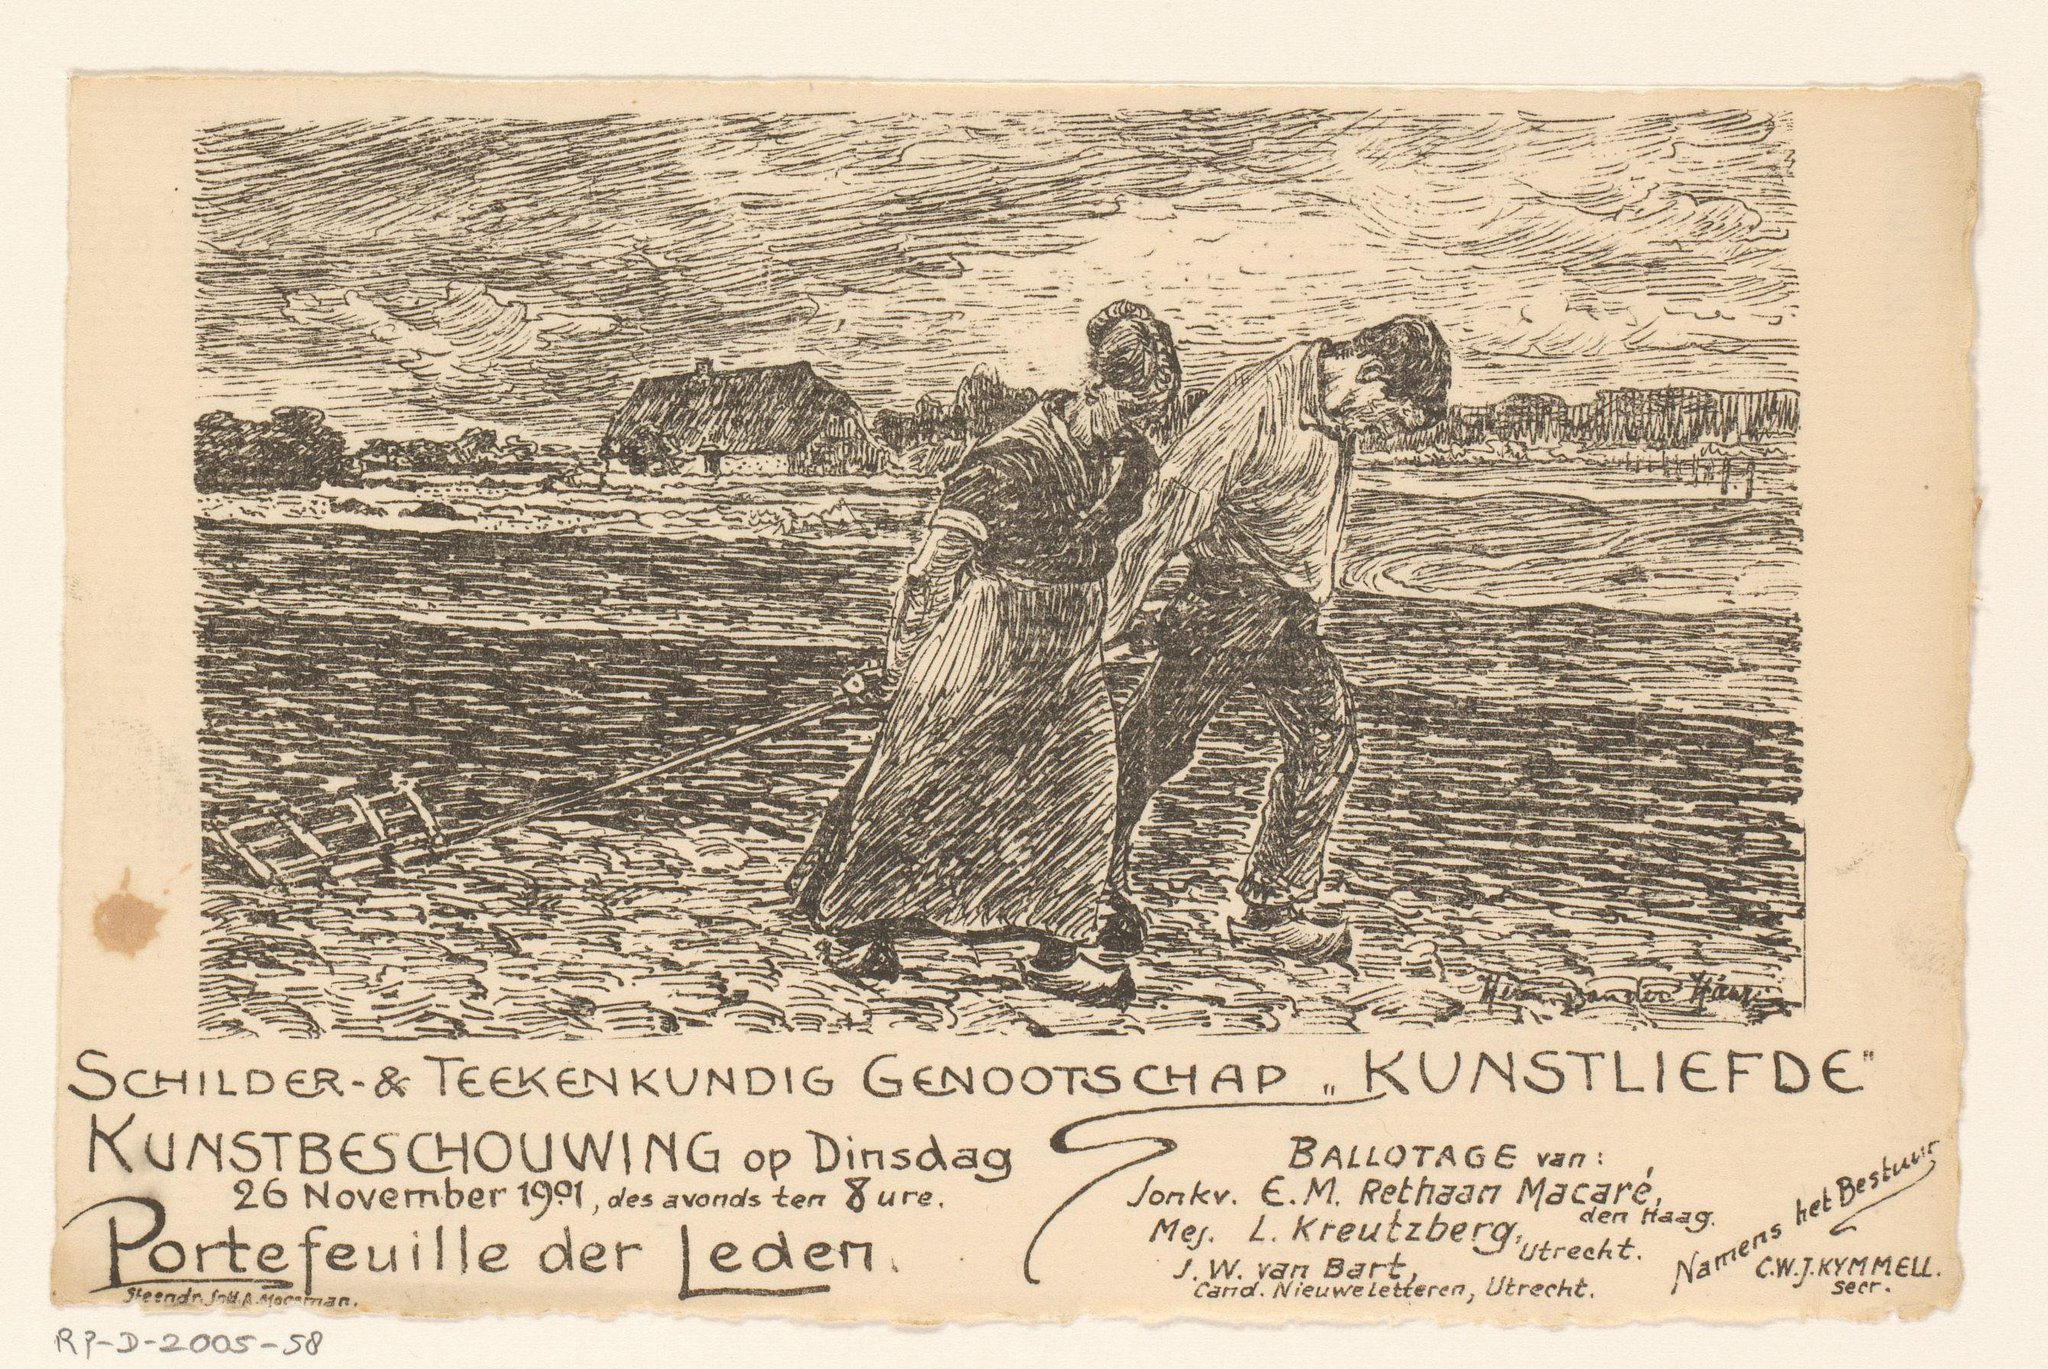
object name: print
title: Uitnodiging van Schilder- en Teekenkundig Genootschap "Kunstliefde" voor een kunstbeschouwing, 26 november 1901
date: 1901-1911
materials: paper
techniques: lithograph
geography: netherlands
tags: criticizing and discussing art, art criticism, circle, club of artists, collecting and exhibiting products of the fine arts, harrowing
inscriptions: collector's mark: Lugt 2228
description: Boer en boerin trekken de eg over het land. Uitnodiging van Schilder- en Teekenkundig Genootschap "Kunstliefde" voor een kunstbeschouwing op 26 november 1901 van de portefeuille van de leden.